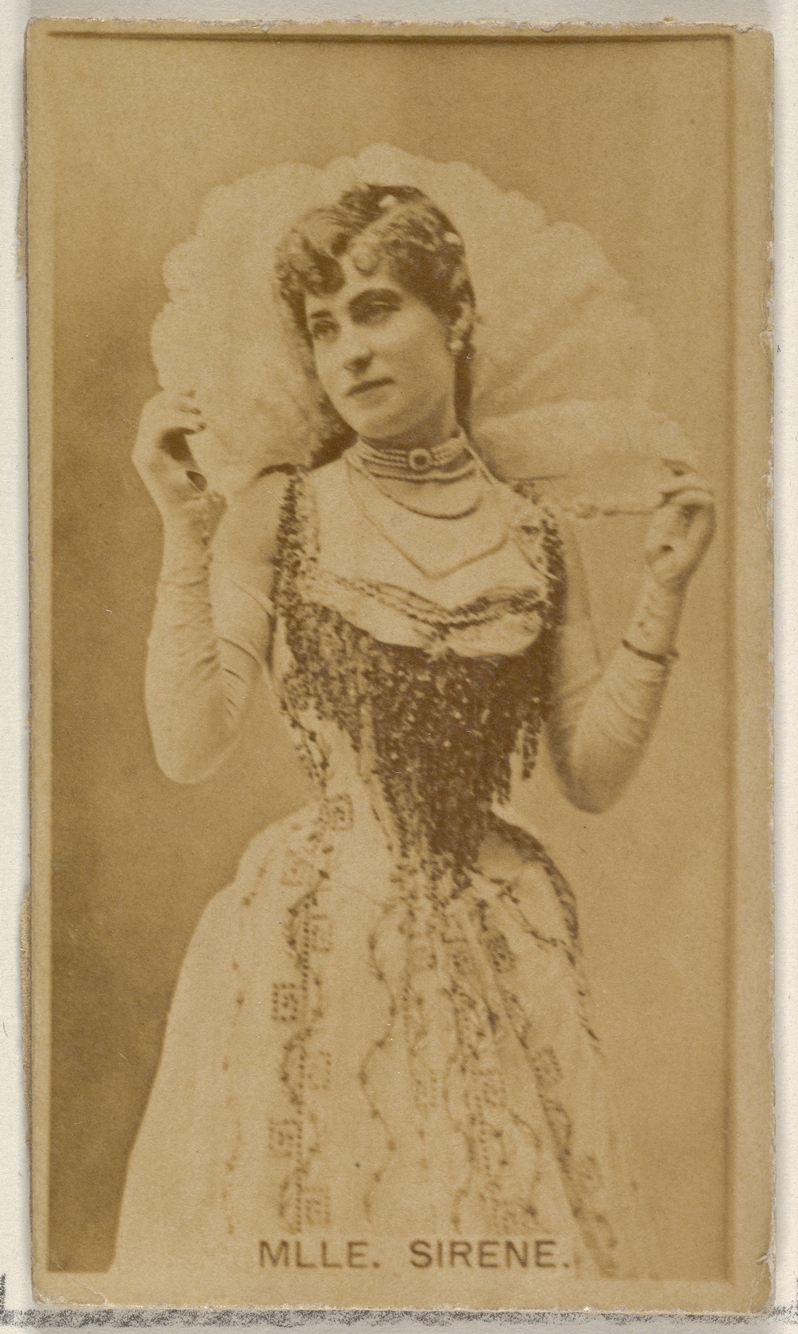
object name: photograph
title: Mlle. Sirene, from the Actors and Actresses series (N45, Type 8) for Virginia Brights Cigarettes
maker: allen & ginter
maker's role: publisher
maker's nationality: american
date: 1888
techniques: albumen silver print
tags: portraits,women,actresses